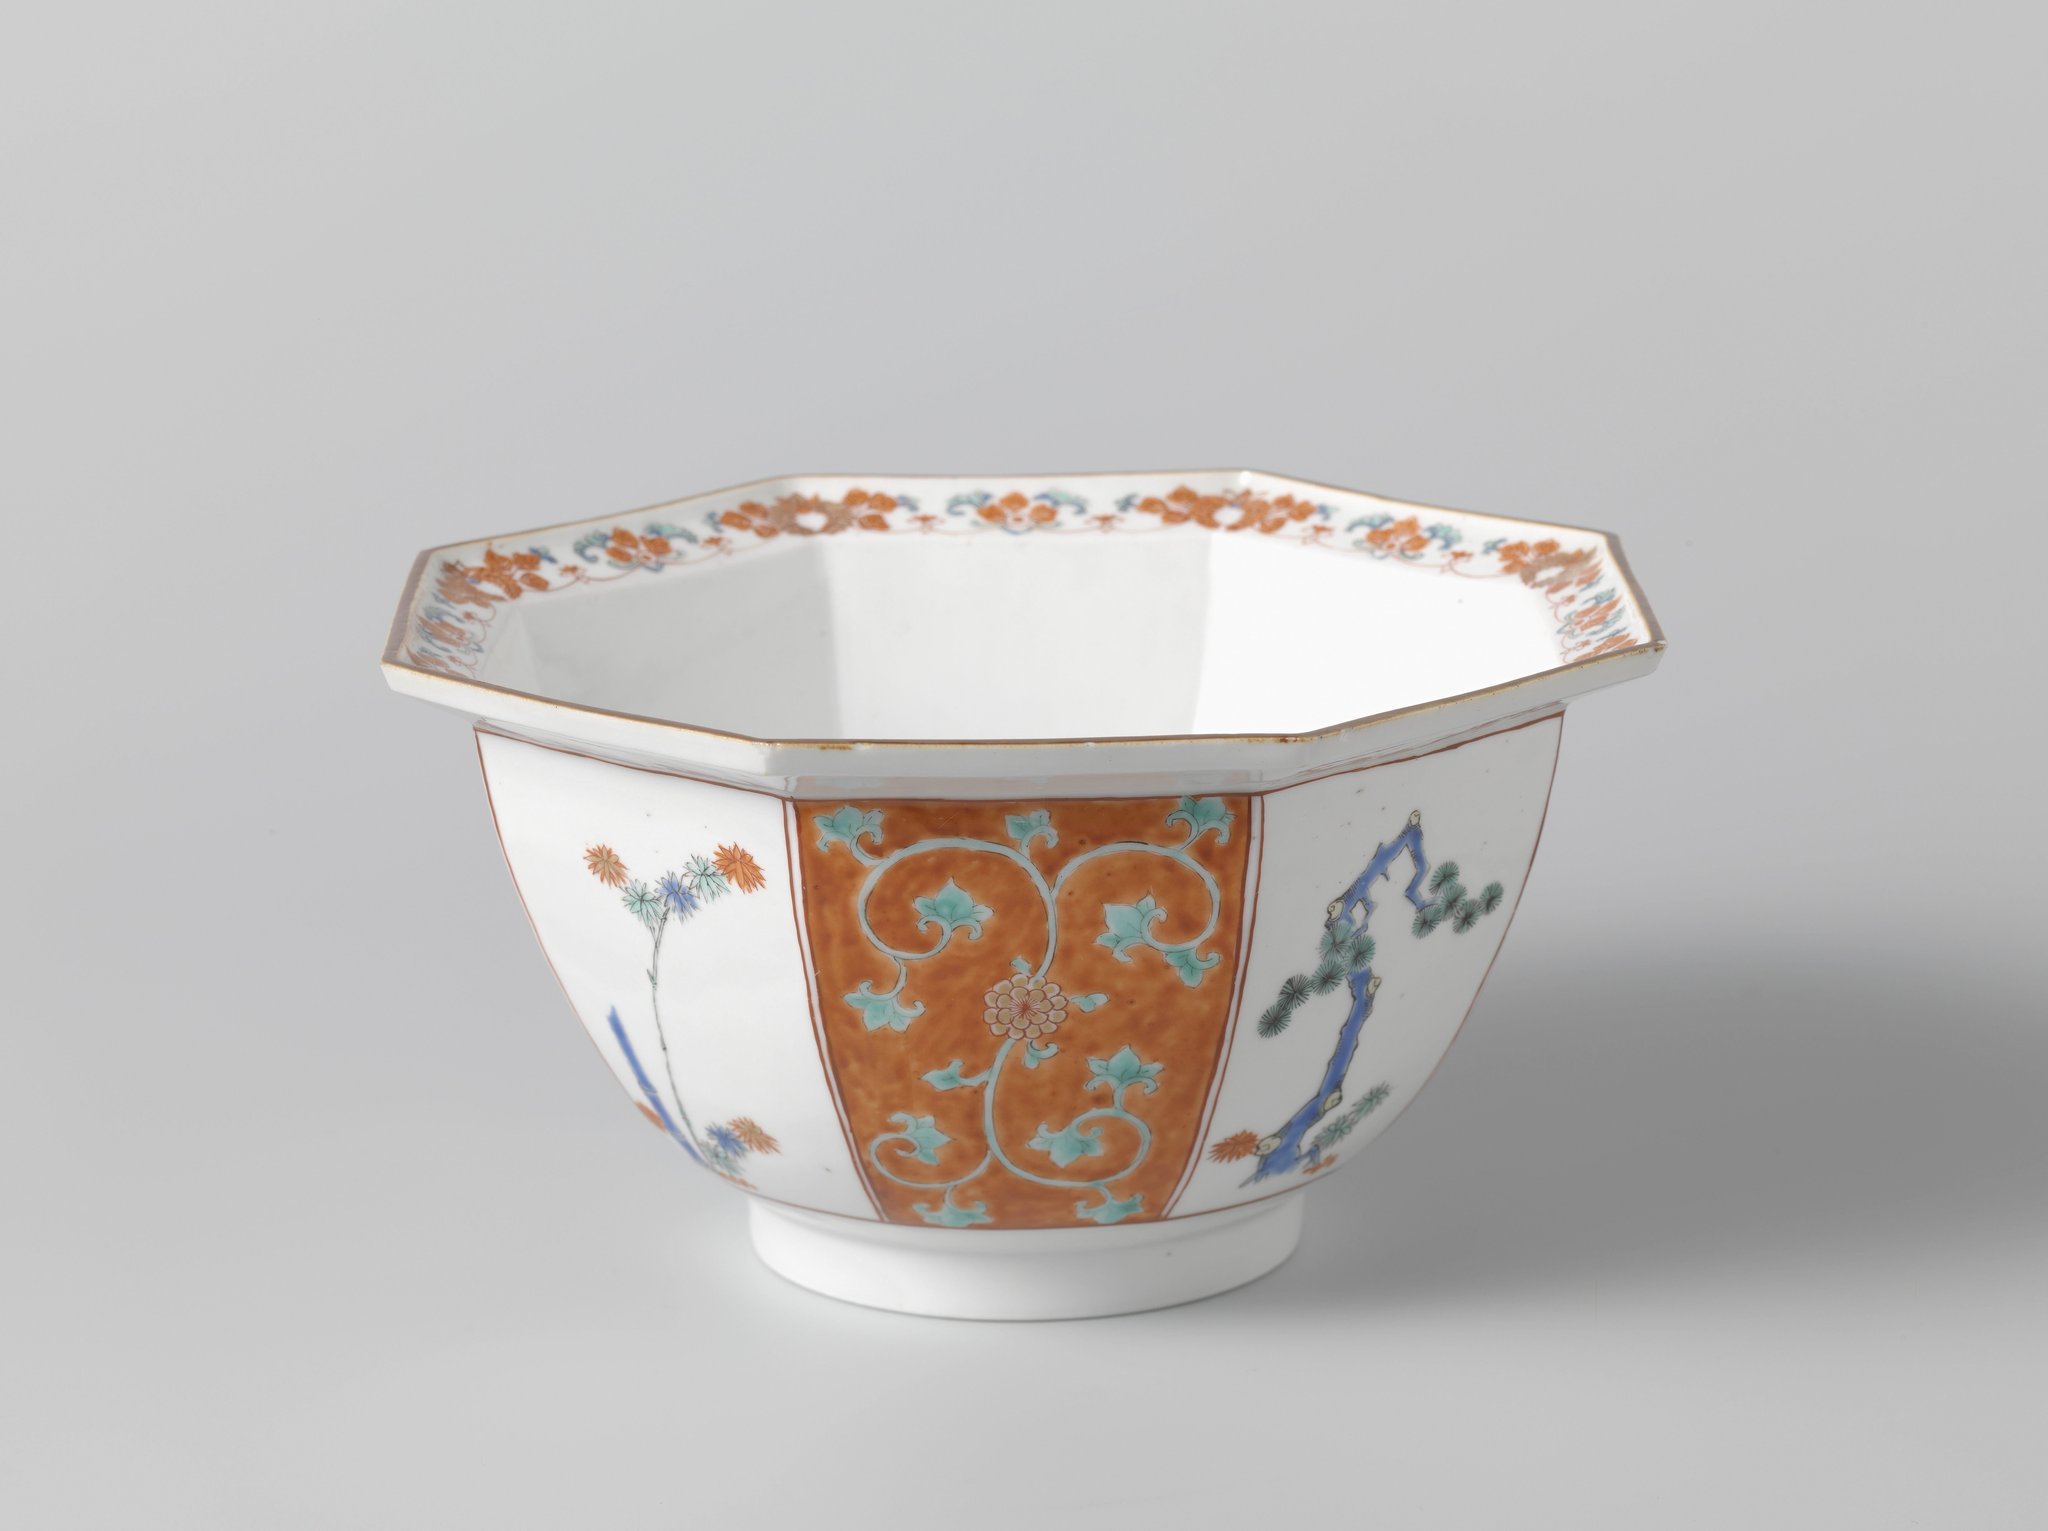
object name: bowl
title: Octagonal bowl with the 'three friends', floral scrolls and hôô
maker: Anonymous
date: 1670-1690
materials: glaze, gold, paint, porcelain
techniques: firing, gilding, turning, vitrification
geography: arita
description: Bowl, c. 1670 - 1690. Jonkvrouwe A.C.A.J. Clifford bequest, 1960.